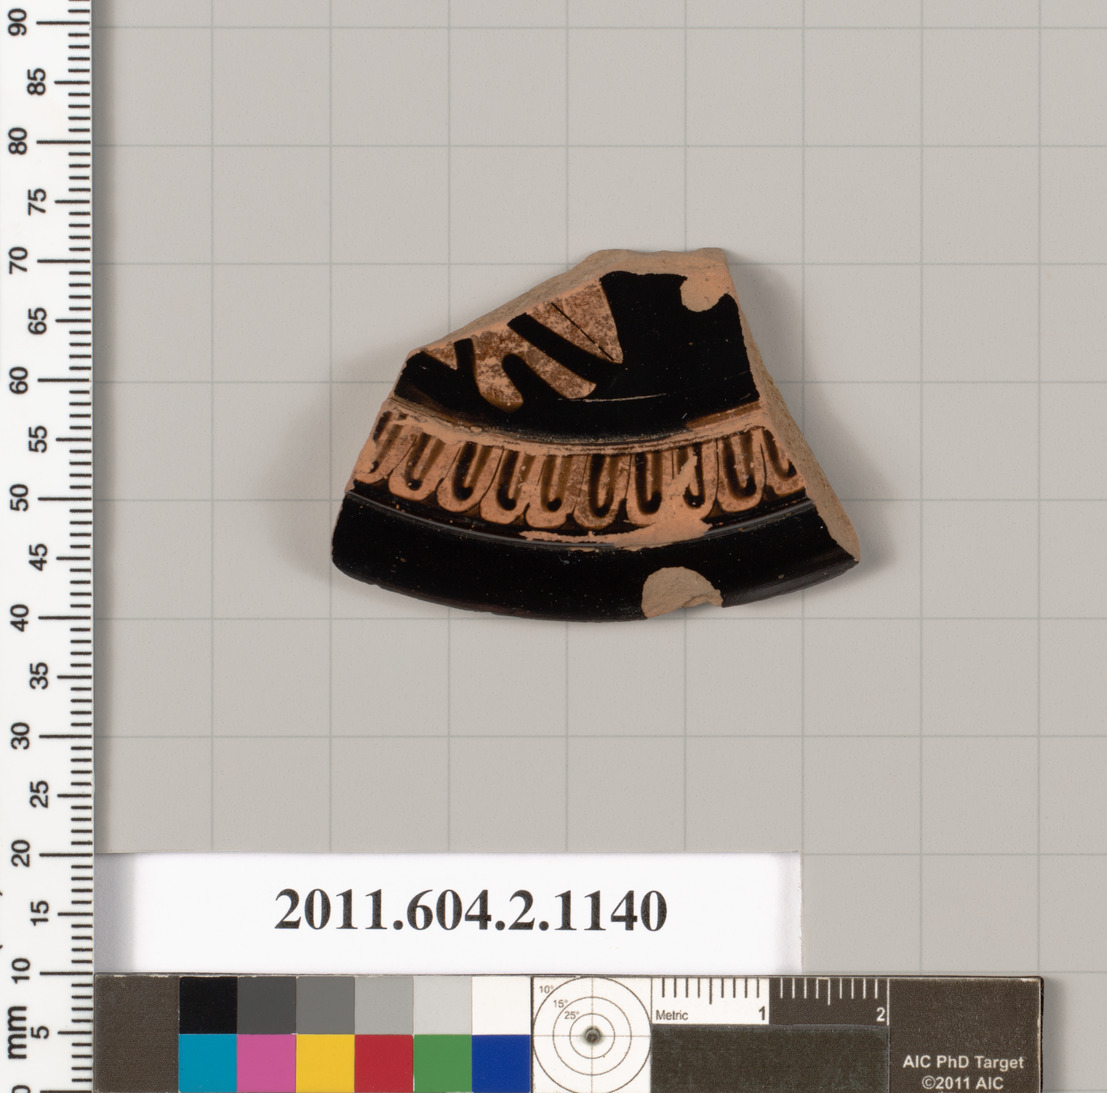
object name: pyxis fragment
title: Terracotta fragment from a pyxis lid (box)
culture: greek, attic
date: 475-451 BCE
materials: terracotta